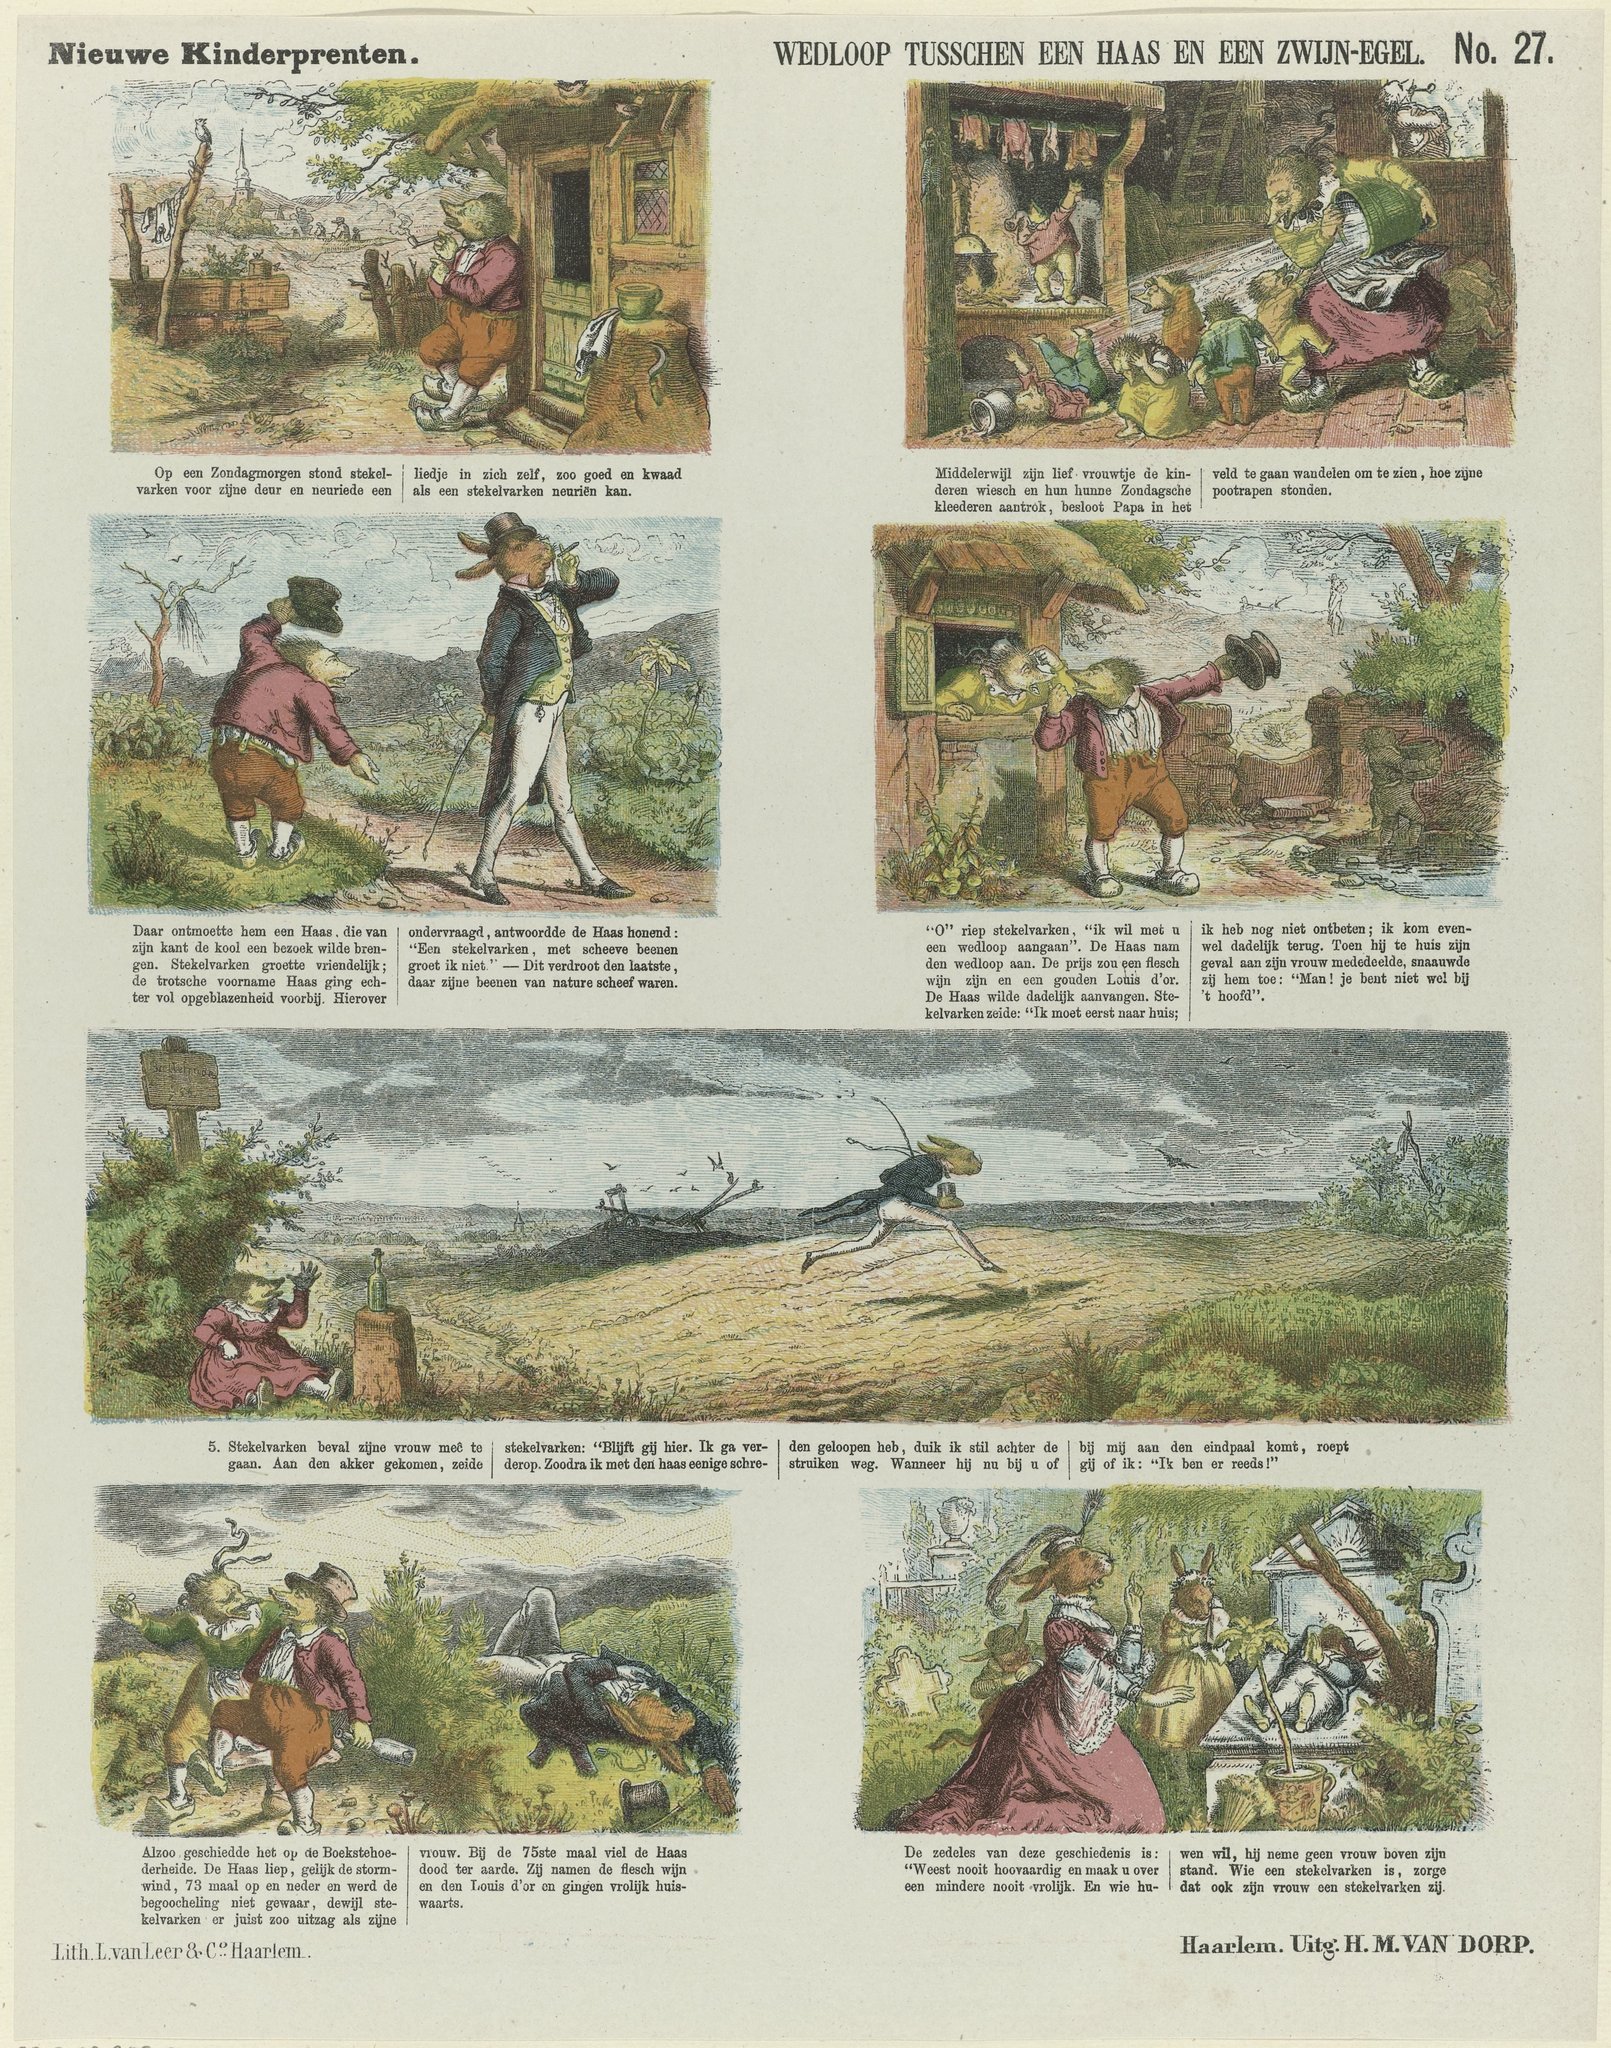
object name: popular print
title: Nieuwe kinderprenten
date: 1872-1883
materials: paper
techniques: lithograph, letterpress printing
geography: haarlem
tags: animals acting as human beings, fables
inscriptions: collector's mark: Lugt 2760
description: Blad met 7 voorstellingen uit een fabel over een wedloop tussen een haas en een zwijn-egel. Onder elke afbeelding een onderschrift. Genummerd rechtsboven: No. 27.